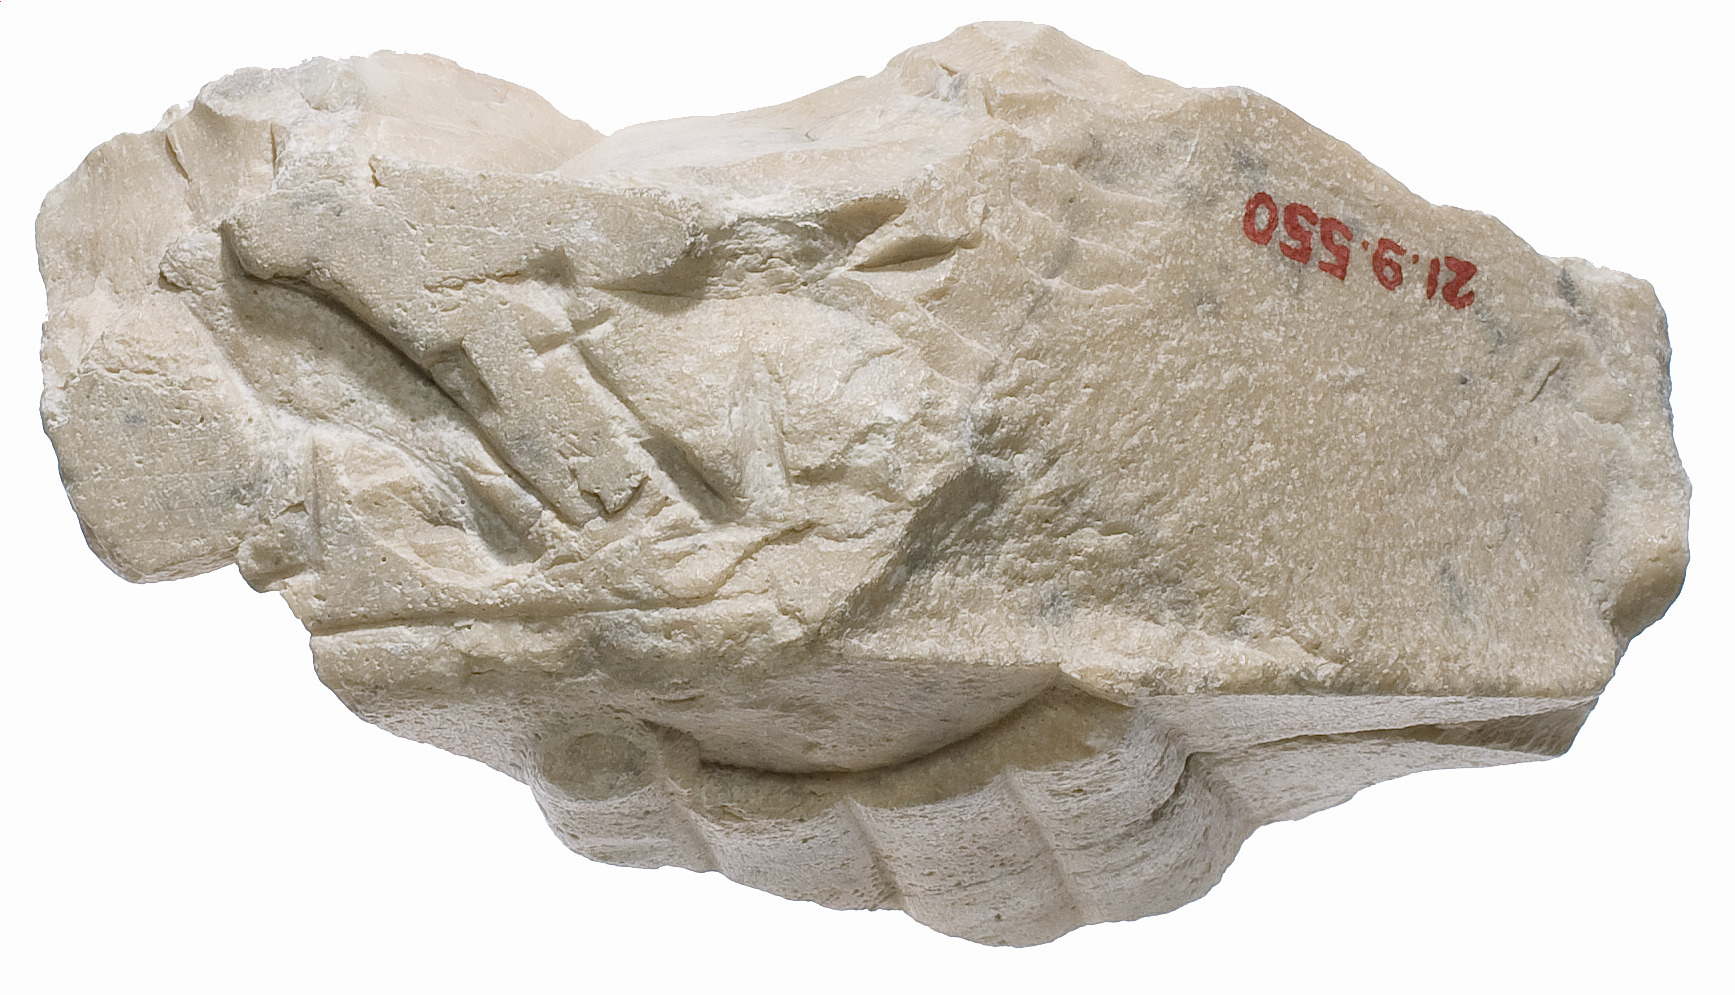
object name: offering table, titulary of king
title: Offering table with hand, titulary of king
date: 1353-1336 BCE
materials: limestone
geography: egypt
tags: hands